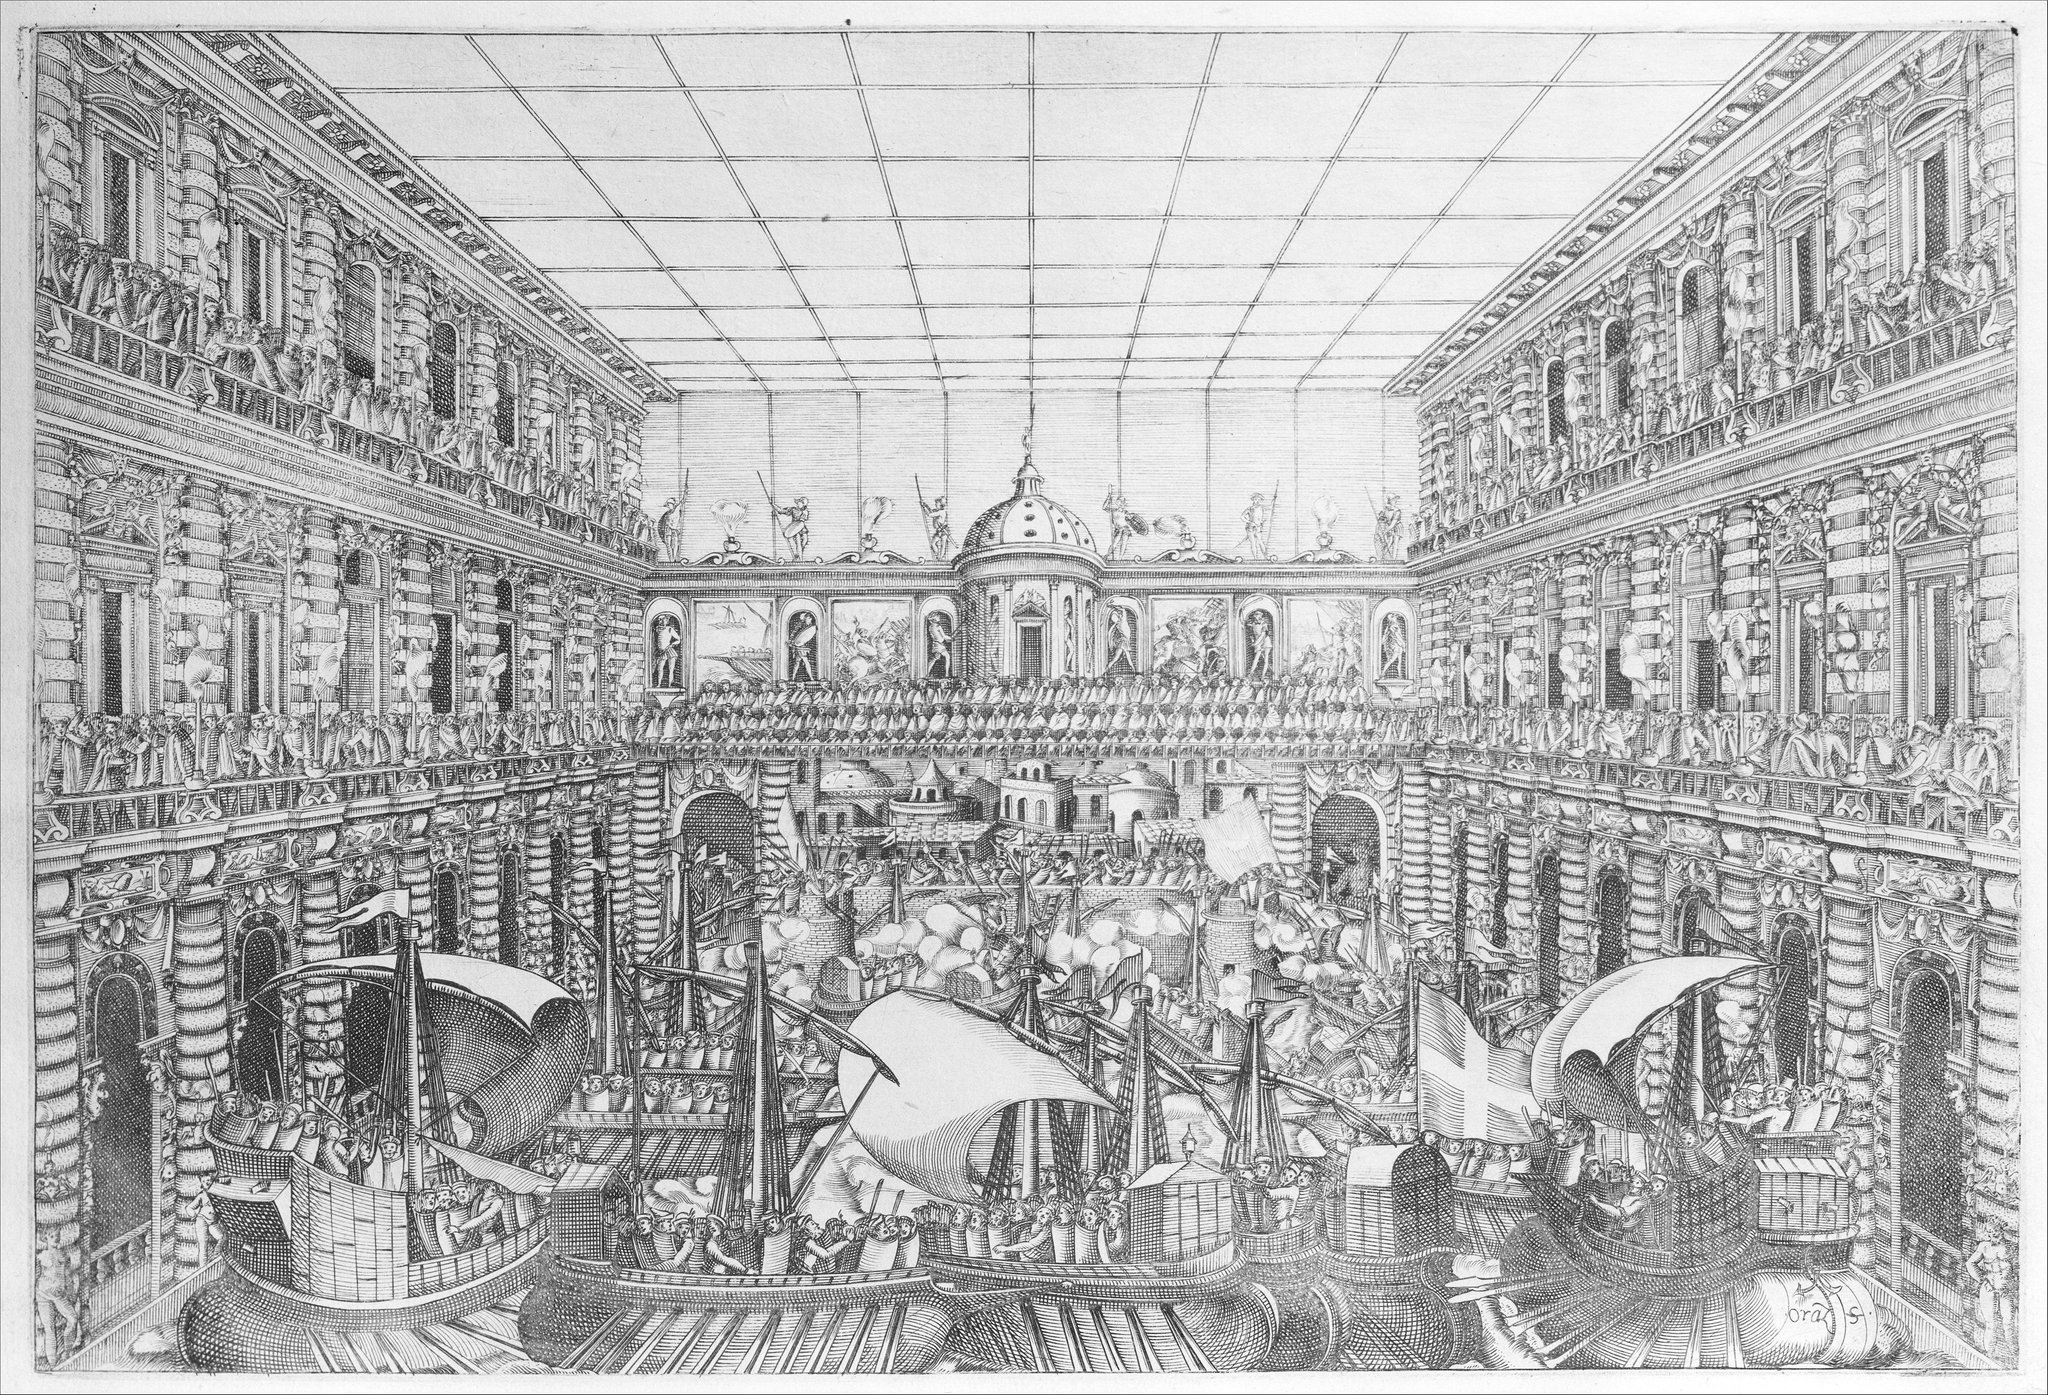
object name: book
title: Naumachia in the Court of Palazzo Pitti, from an Album with Plates documenting the Festivities of the 1589 Wedding of Arch Duke Ferdinand I de’ Medici and Christine of Lorraine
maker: orazio scarabelli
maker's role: artist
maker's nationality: italian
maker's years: 1589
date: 1589-1592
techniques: etching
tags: battles,ships